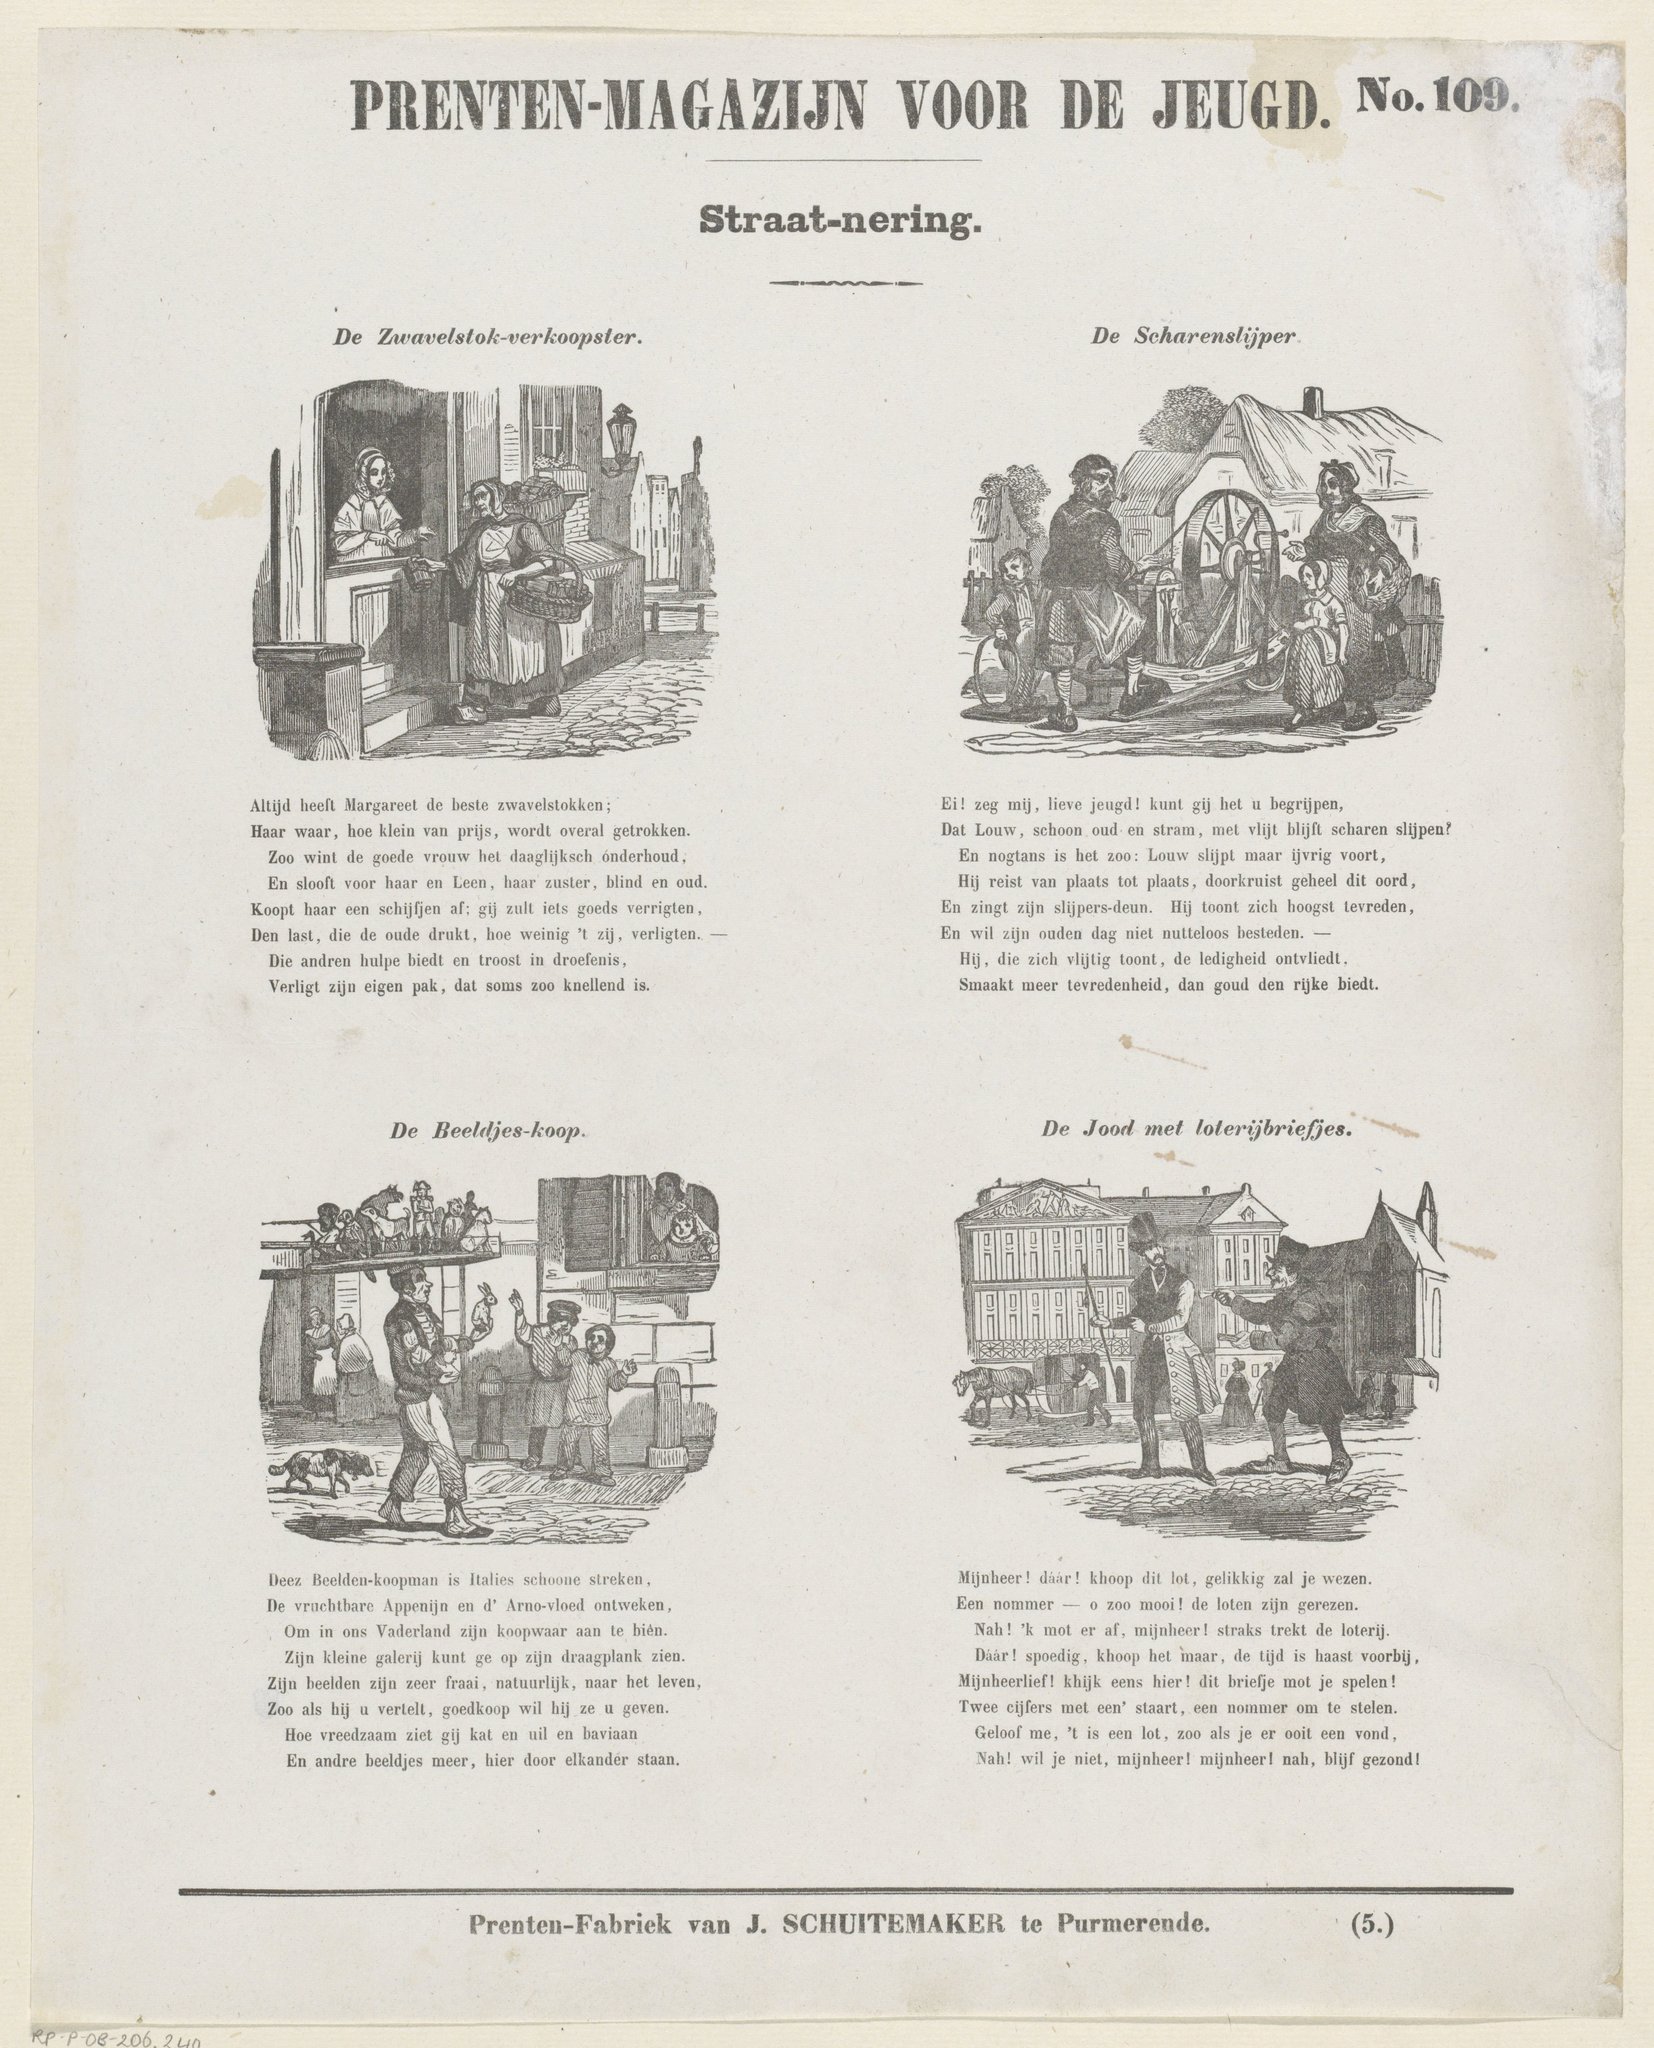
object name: print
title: Straatverkopers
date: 1850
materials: paper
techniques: letterpress printing, engraving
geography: purmerend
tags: street-trader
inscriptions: collector's mark: Lugt 2760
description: Na voltooiing van de acht jaargangen van de reeks 'Prenten-magazijn voor de jeugd' in 1850 heeft Jan Schuitemaker al deze prenten heruitgegeven en omgenummerd als nr. 1 t/m 192. De oorspronkelijke jaargang wordt telkens nog vermeld rechtsonder op de prent. Binnen de jaargangen zijn prenten van hetzelfde thema in clusters van vier achter elkaar gezet.